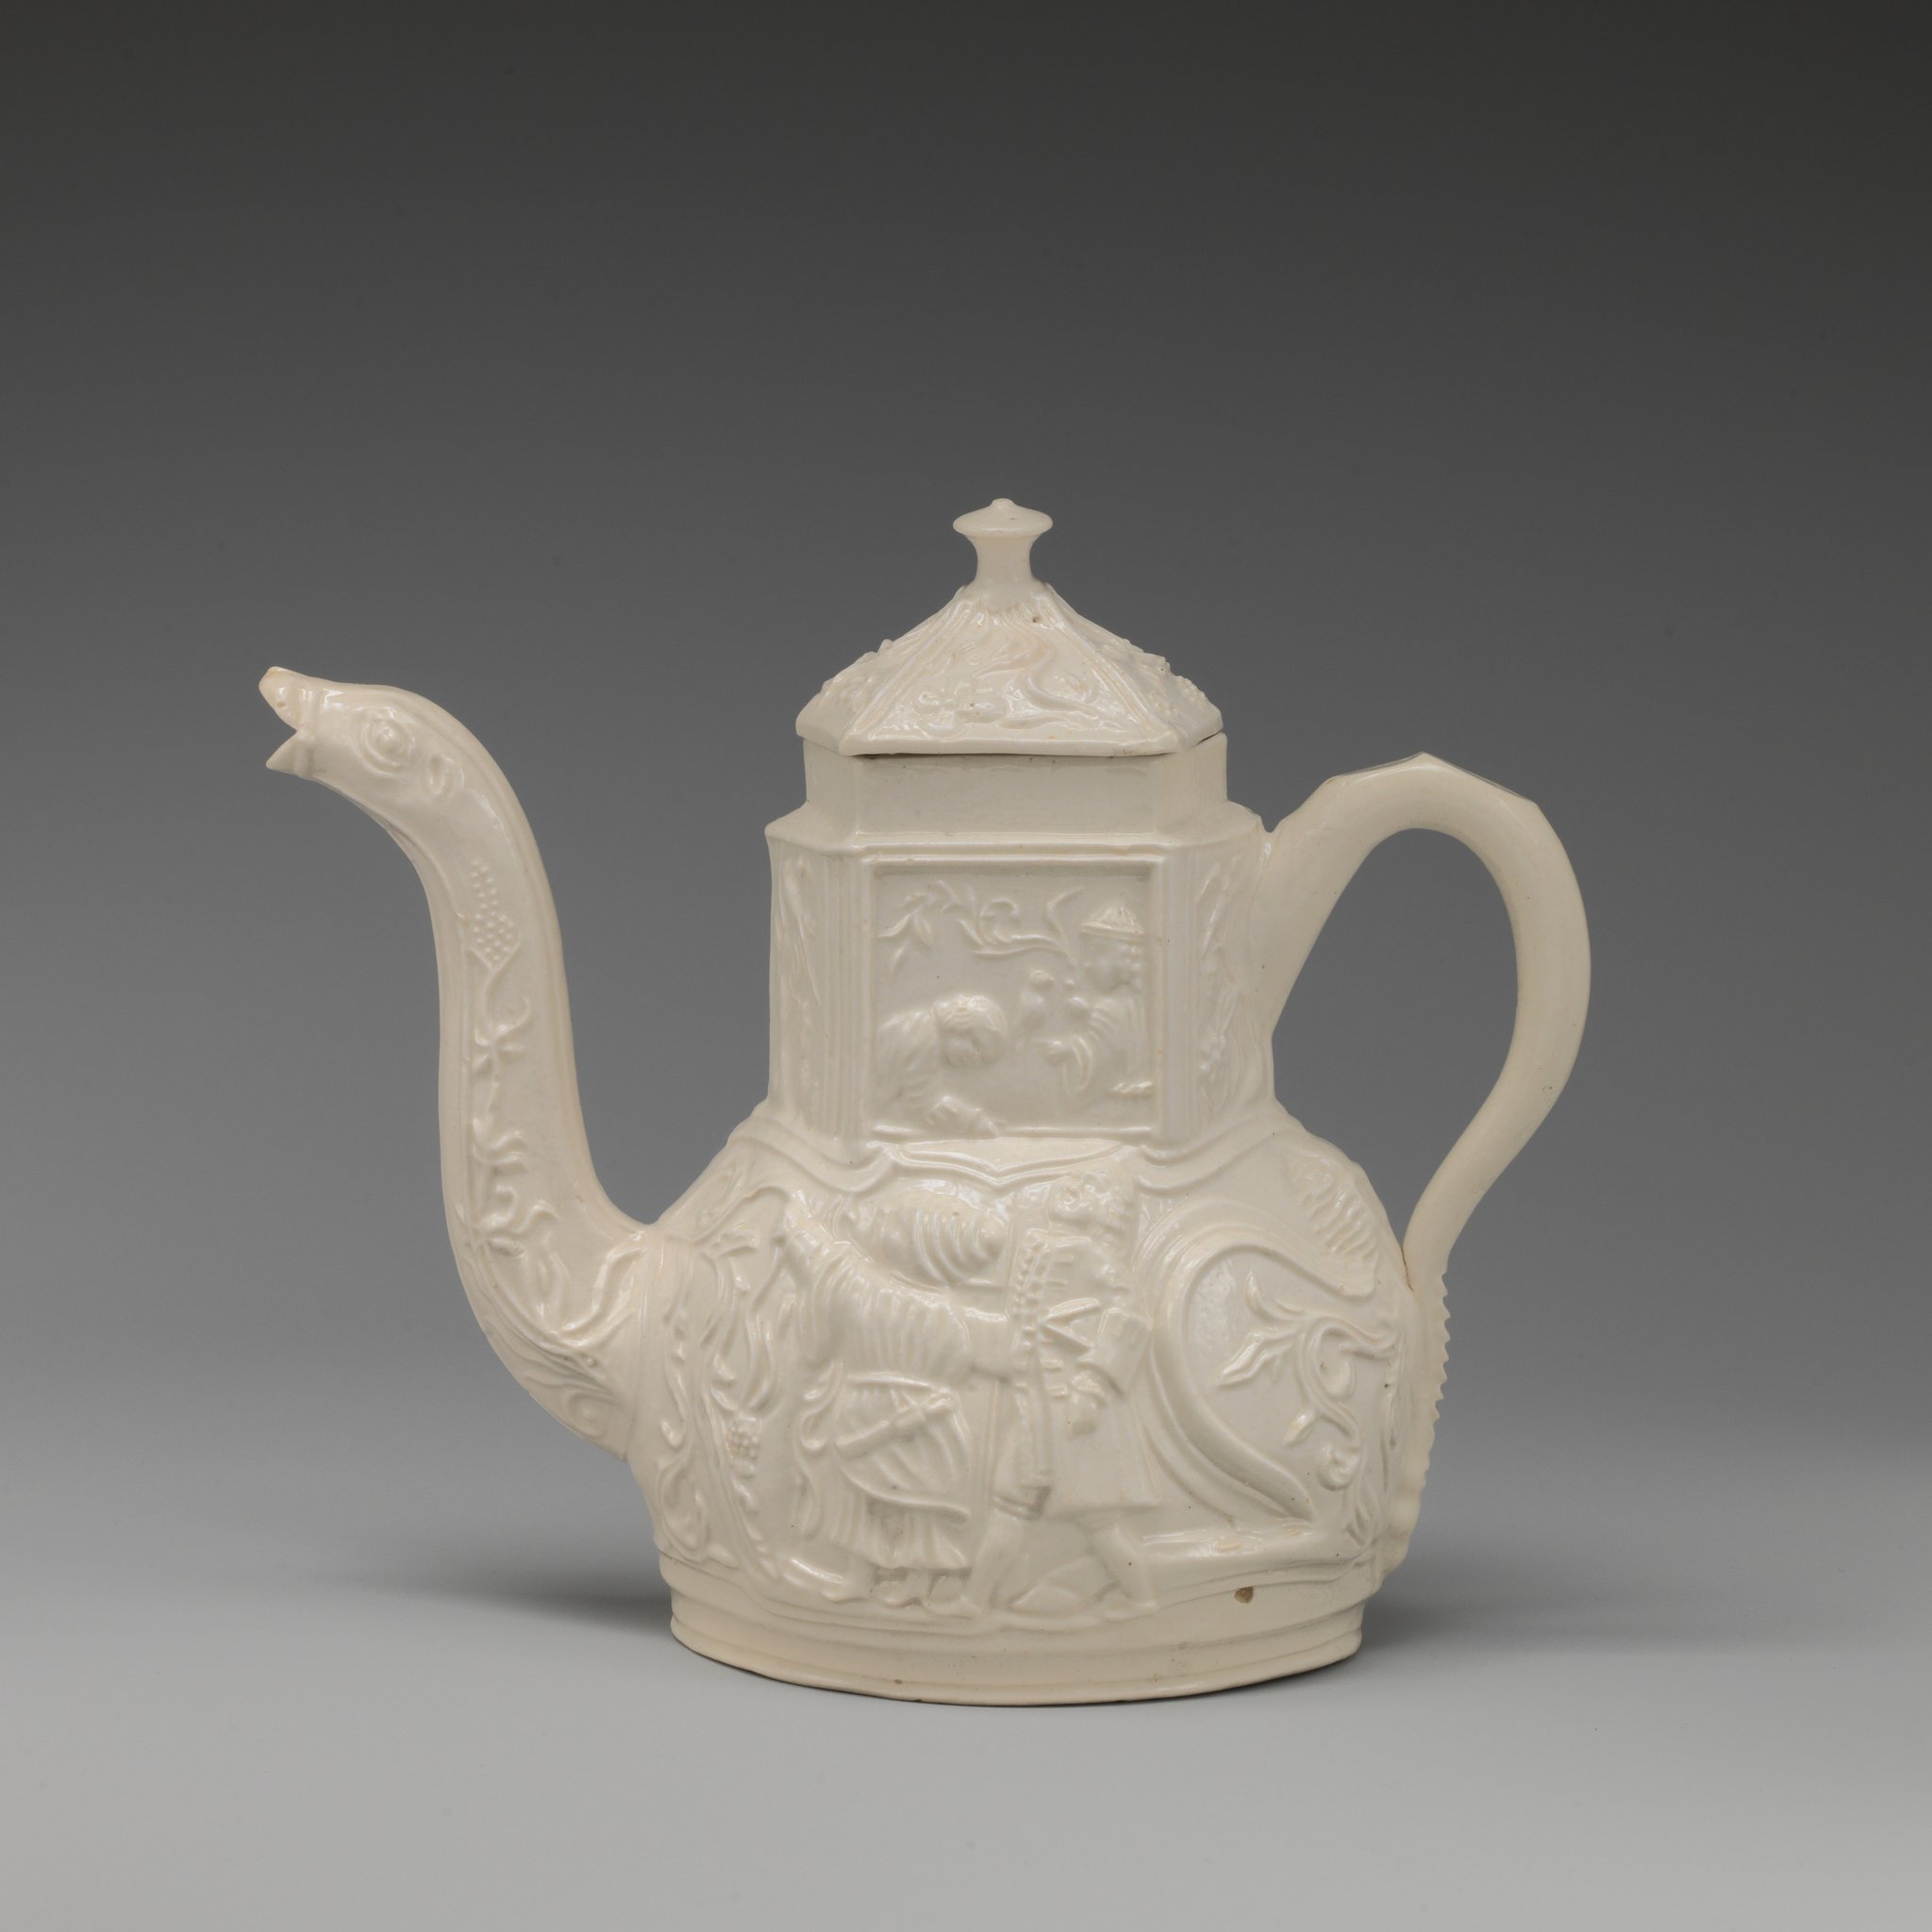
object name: teapot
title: Teapot in the form of a camel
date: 1745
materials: stoneware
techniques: salt glaze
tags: human figures